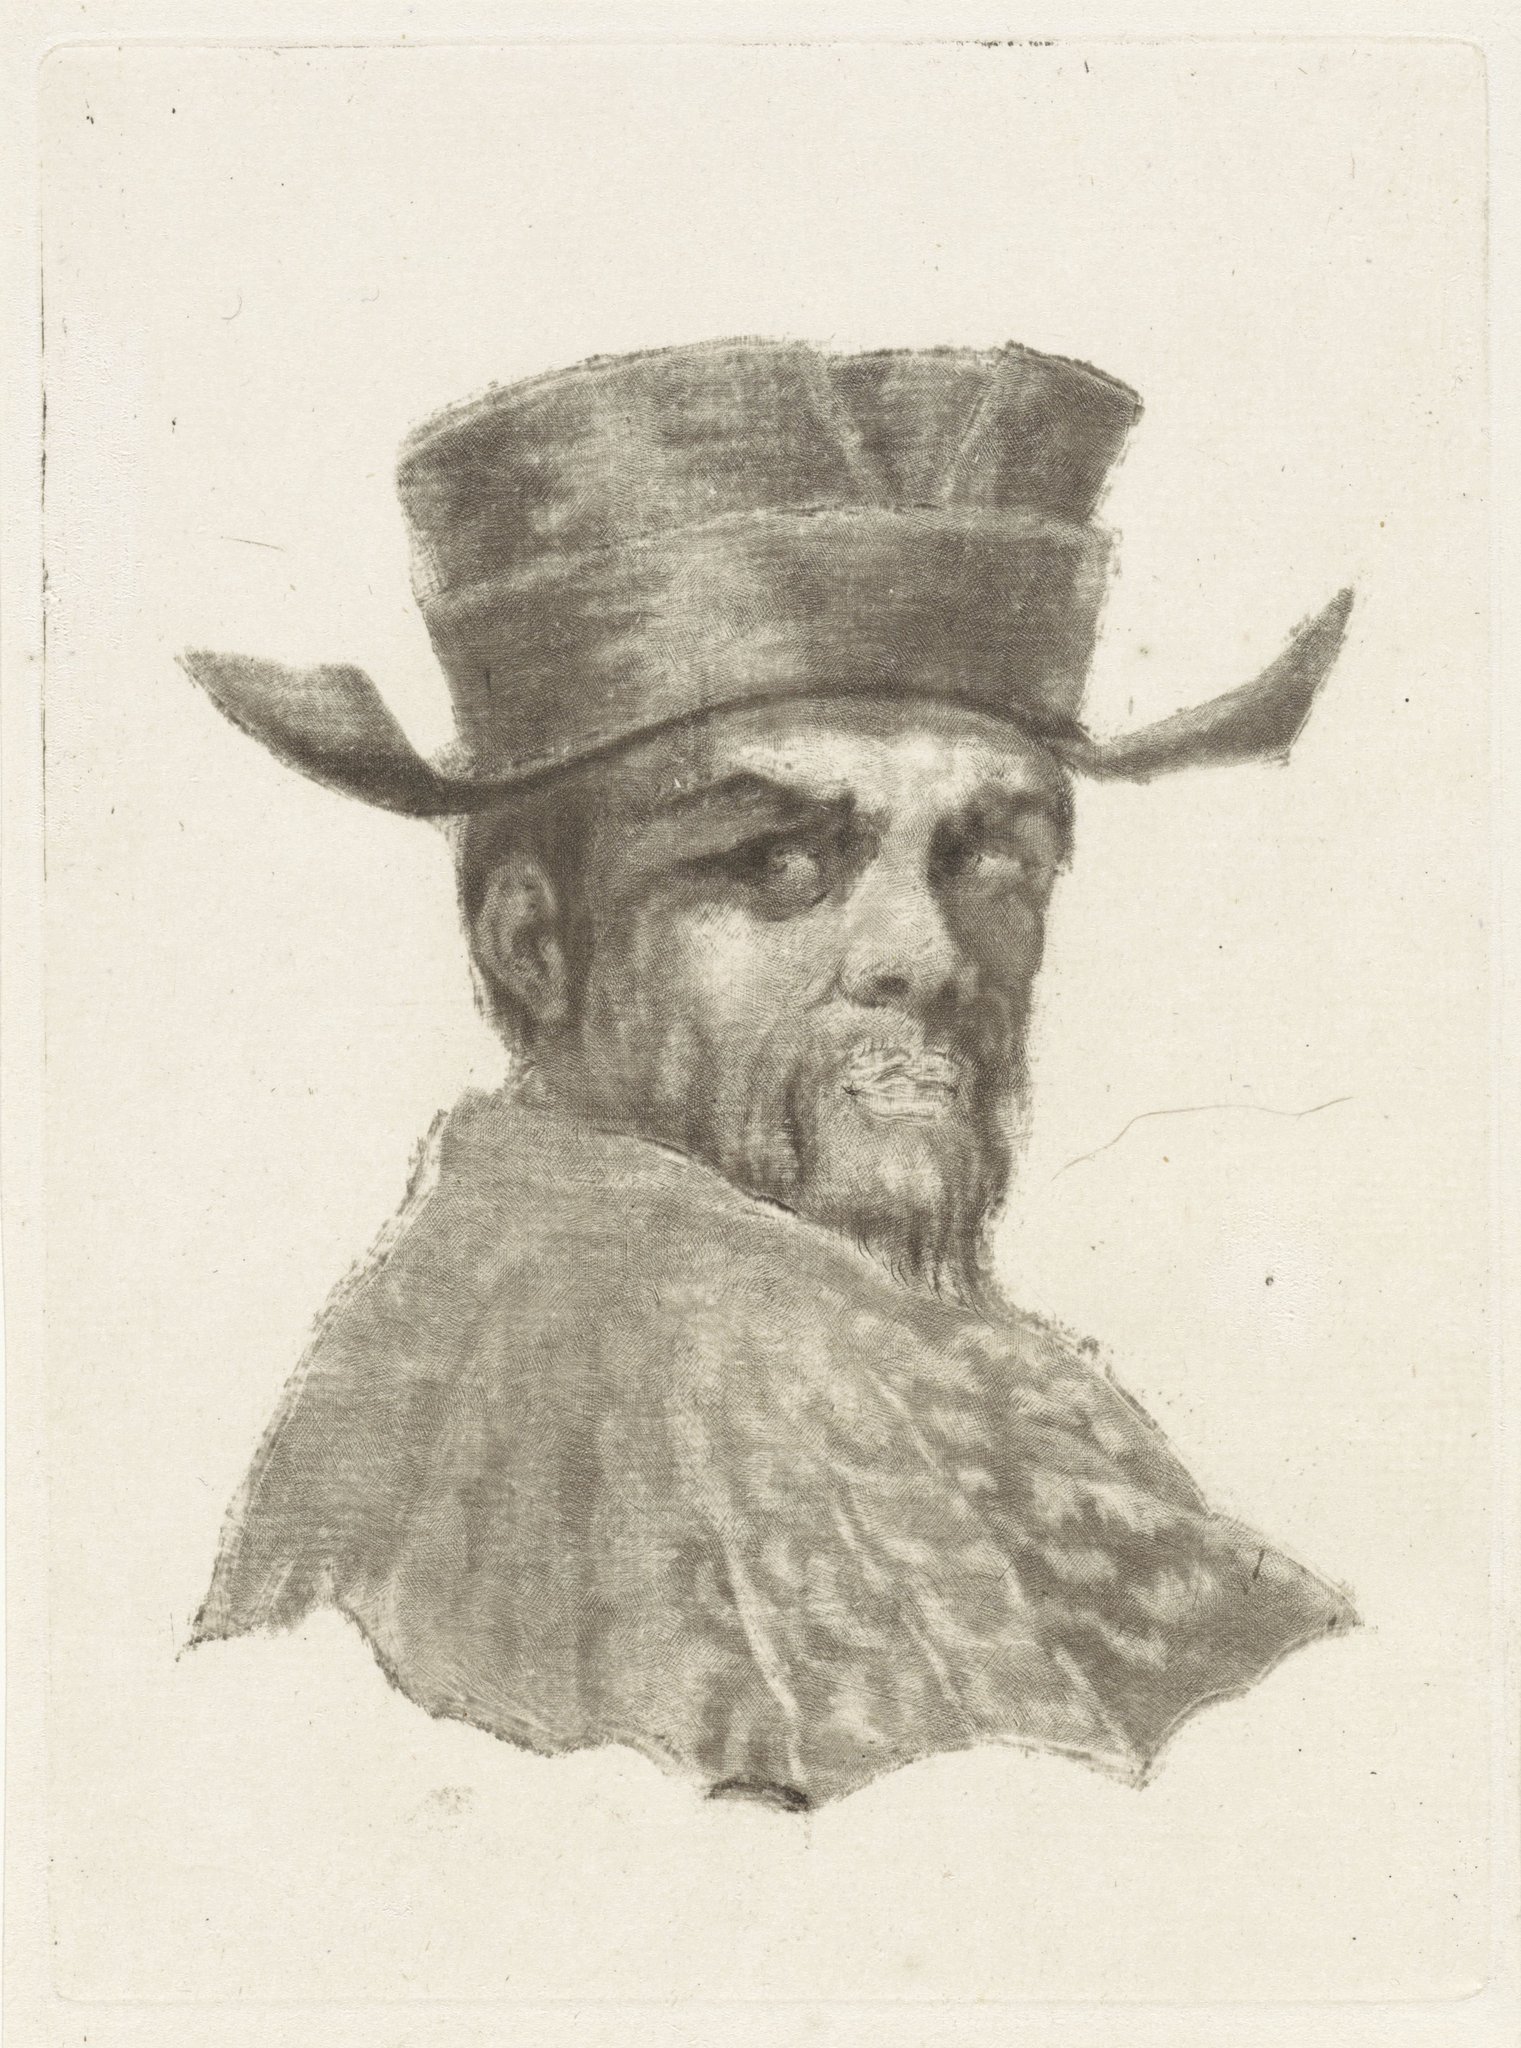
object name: print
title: Buste van een man met een hoed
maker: dirk van der toorn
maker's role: print maker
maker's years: 1778-1811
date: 1788-1811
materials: paper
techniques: mezzotint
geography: the hague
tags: head-gear: hat (+ men's clothes)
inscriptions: collector's mark: Lugt 2228